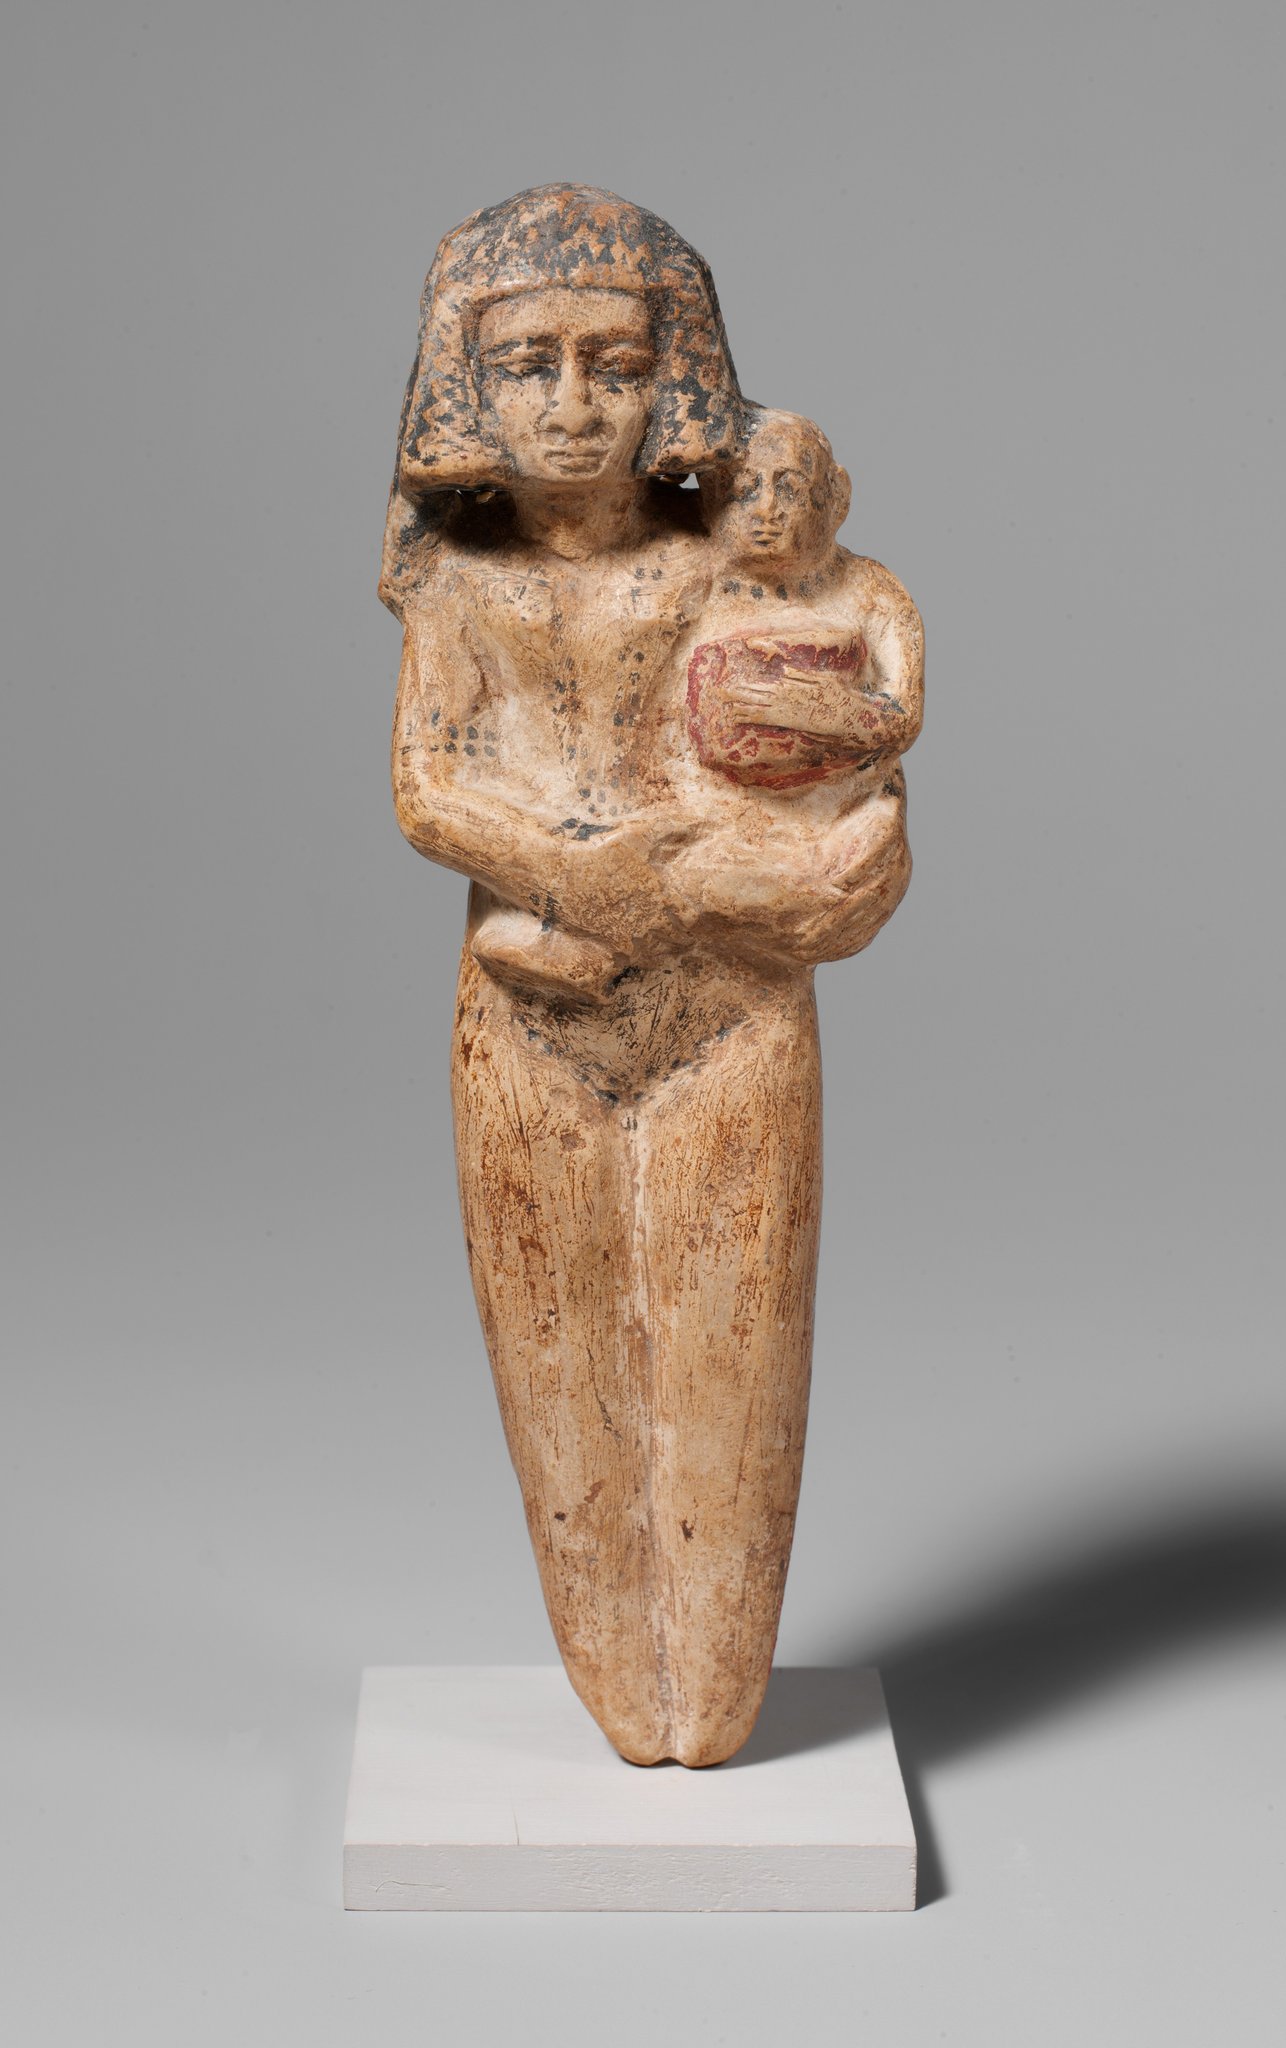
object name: statuette of a woman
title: Female figure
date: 1981-1550 BCE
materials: limestone, paint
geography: egypt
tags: children,women